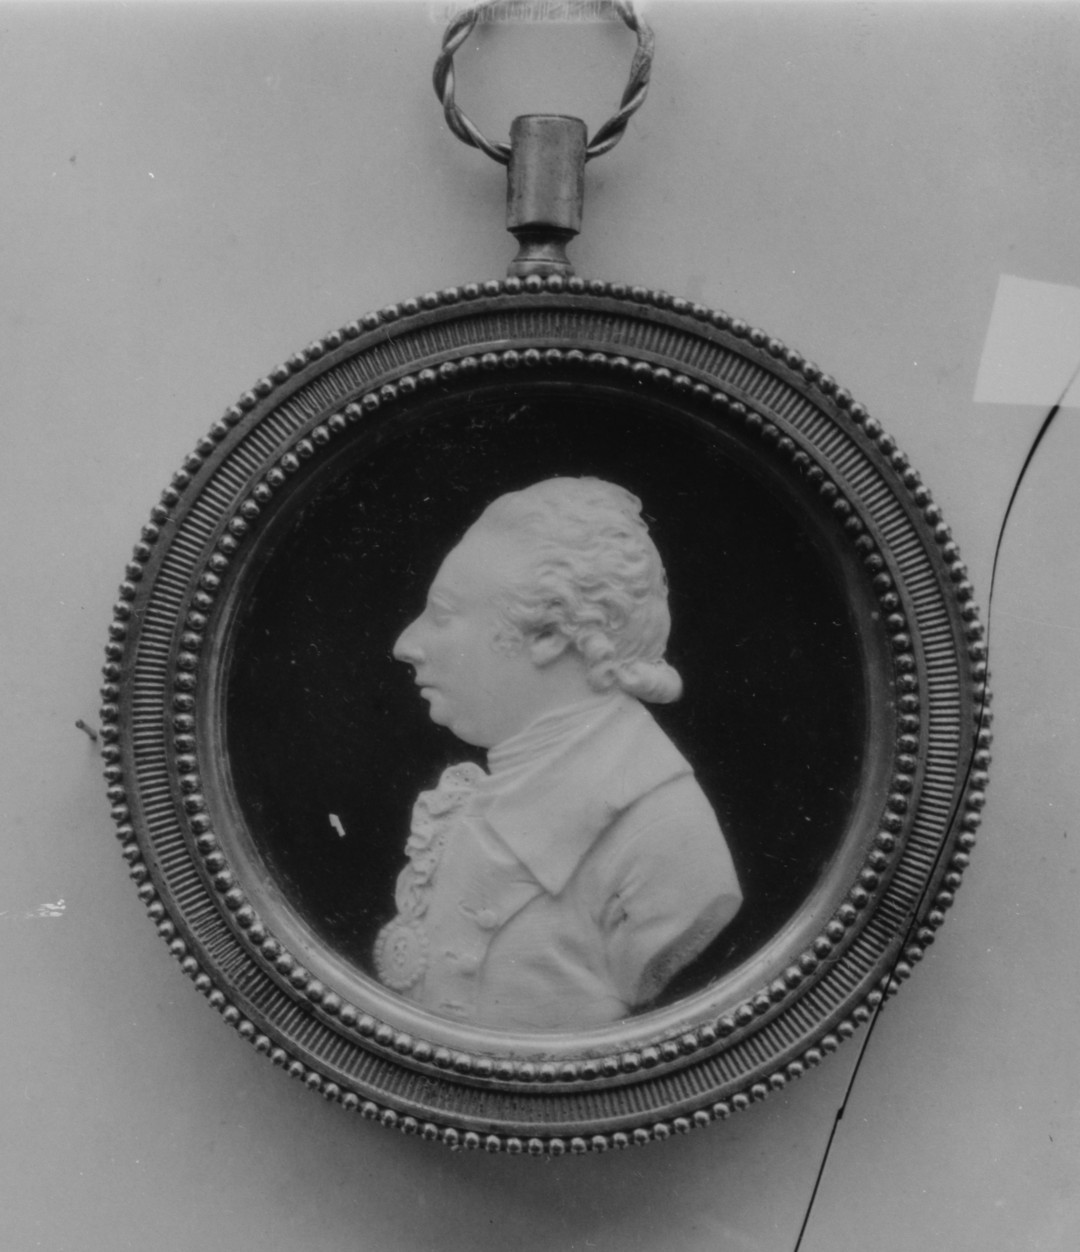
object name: relief bust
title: A man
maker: marie honoré renaud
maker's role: artist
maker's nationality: french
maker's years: 1797-1856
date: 1800-1850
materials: wax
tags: men,profiles